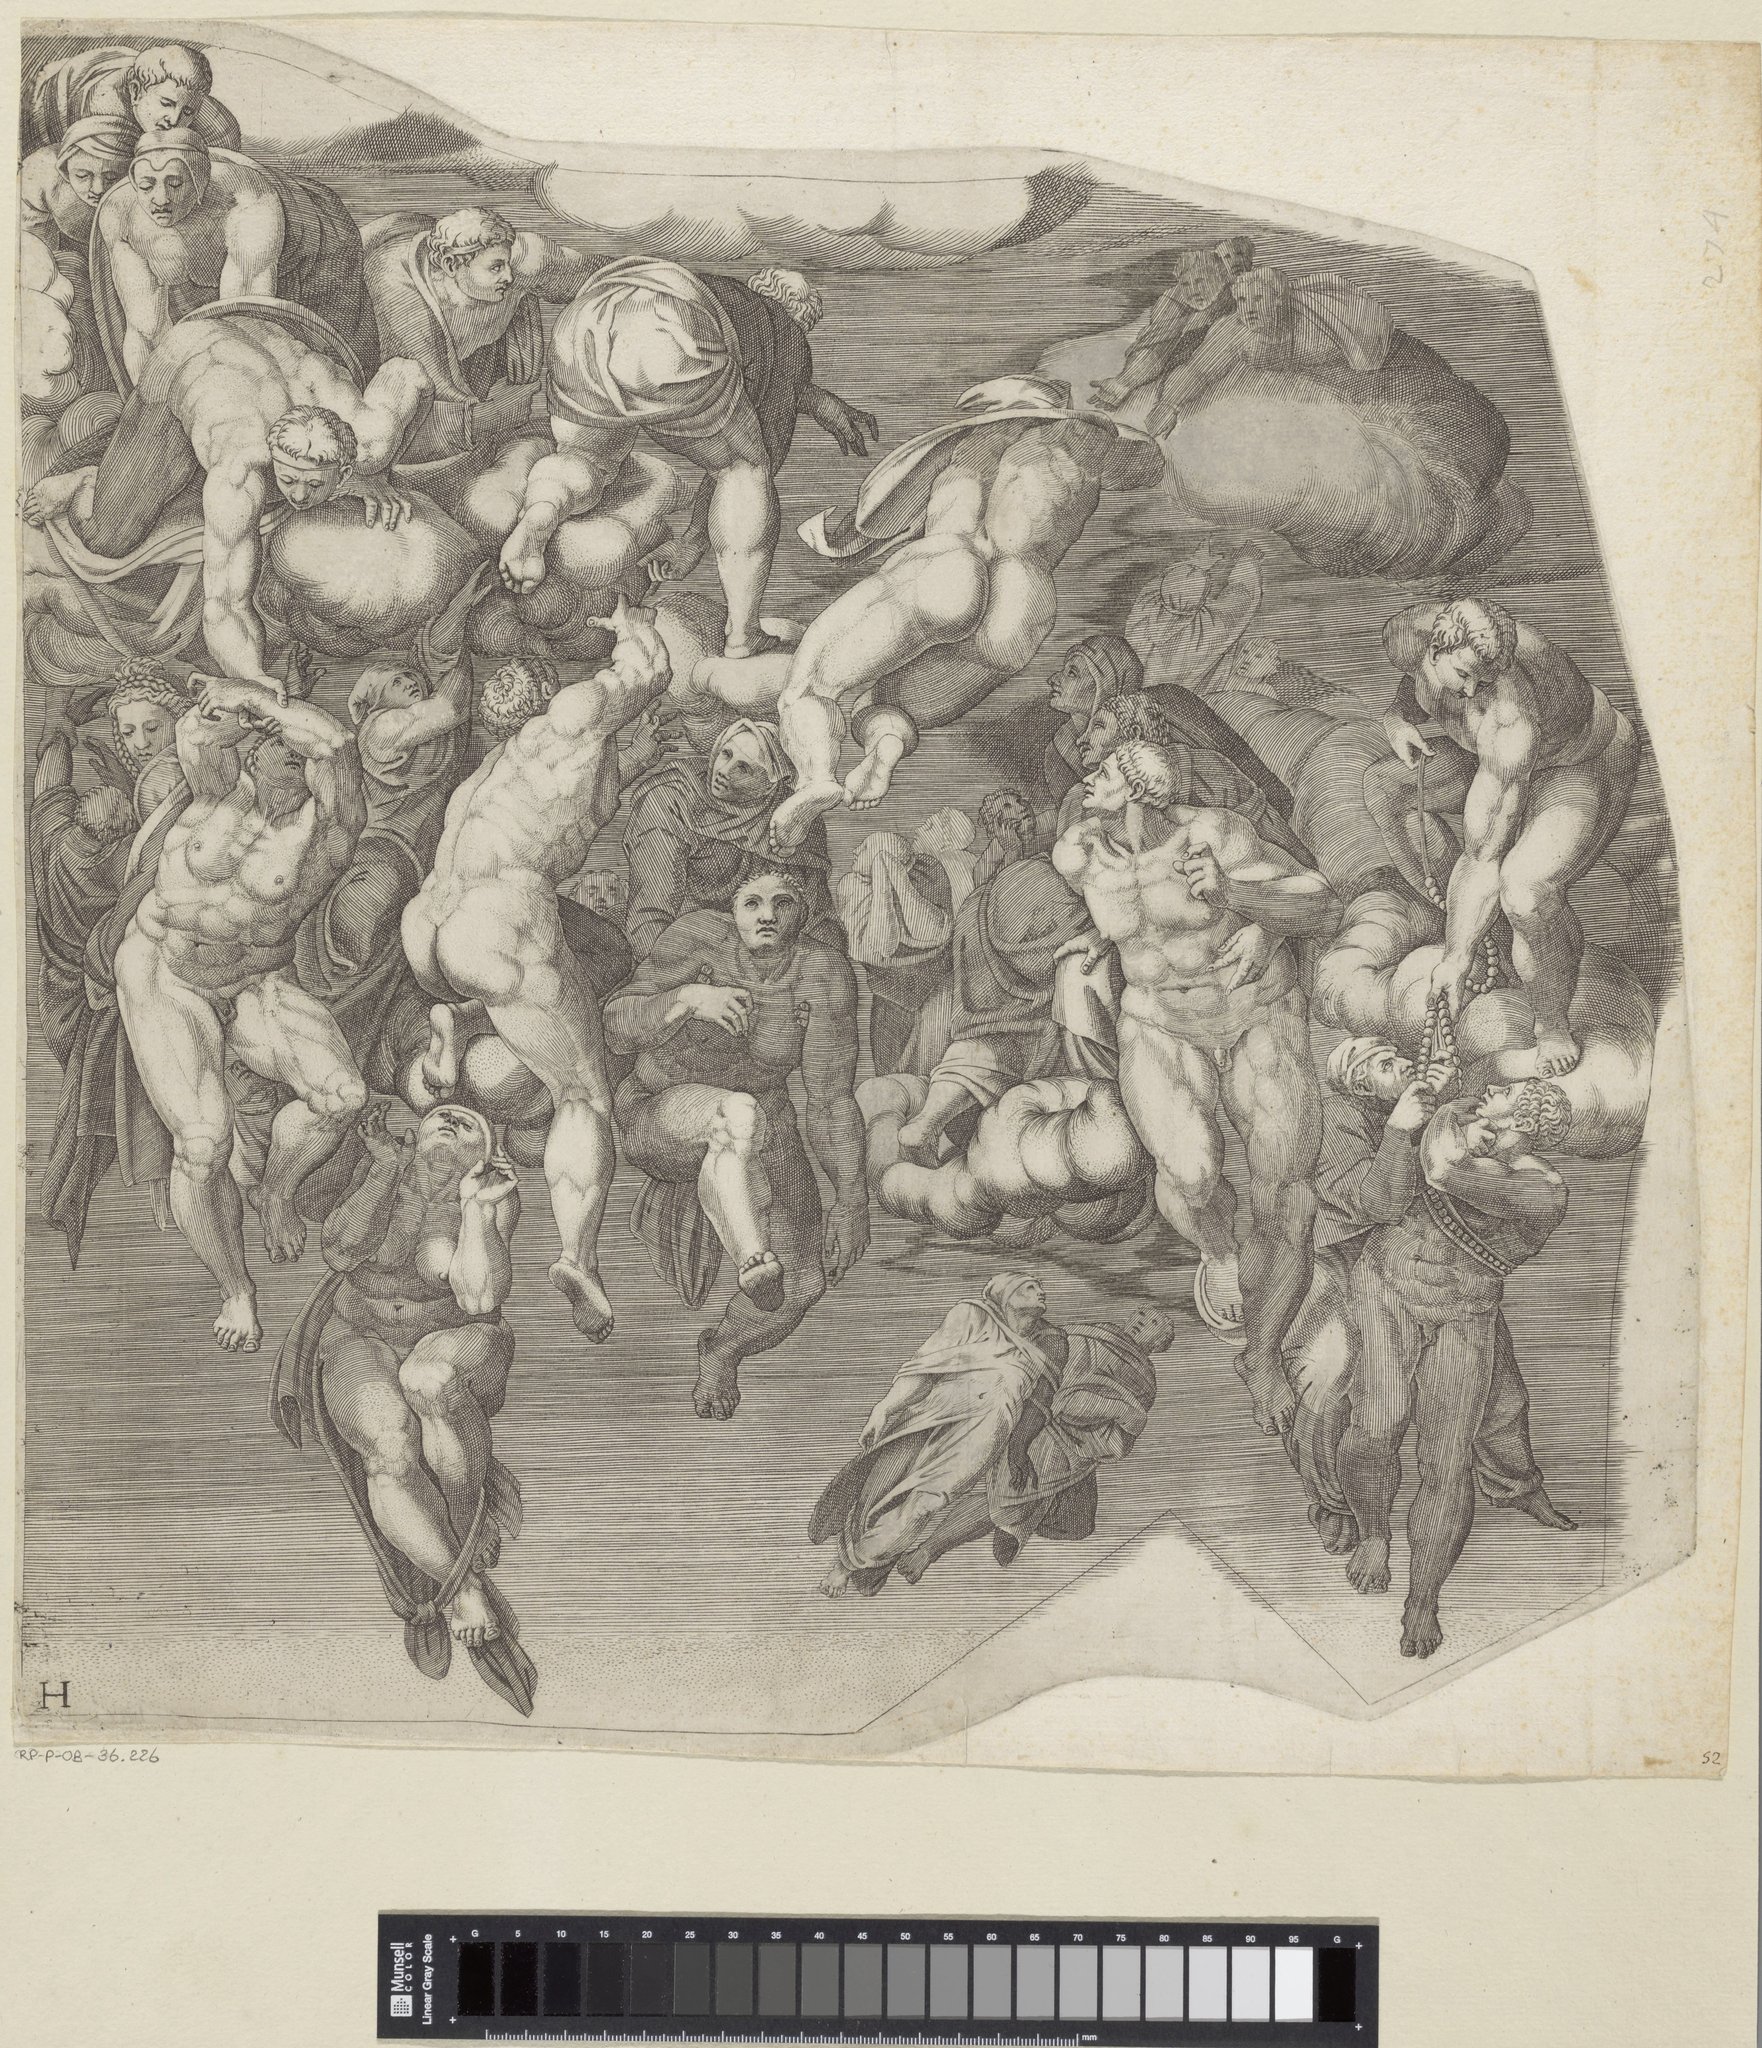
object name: print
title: Het laatste oordeel, blad H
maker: giorgio ghisi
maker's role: print maker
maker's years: 1520-1582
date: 1530-1582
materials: paper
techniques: engraving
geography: vatican city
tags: last judgement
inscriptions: collector's mark: Lugt 240, number: ‘52’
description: Prent maakt deel uit van een groep van tien prenten die samen één grote voorstelling vormen naar het fresco met het Laatste Oordeel door Michelangelo in de Sixtijnse Kapel in het Vaticaan.